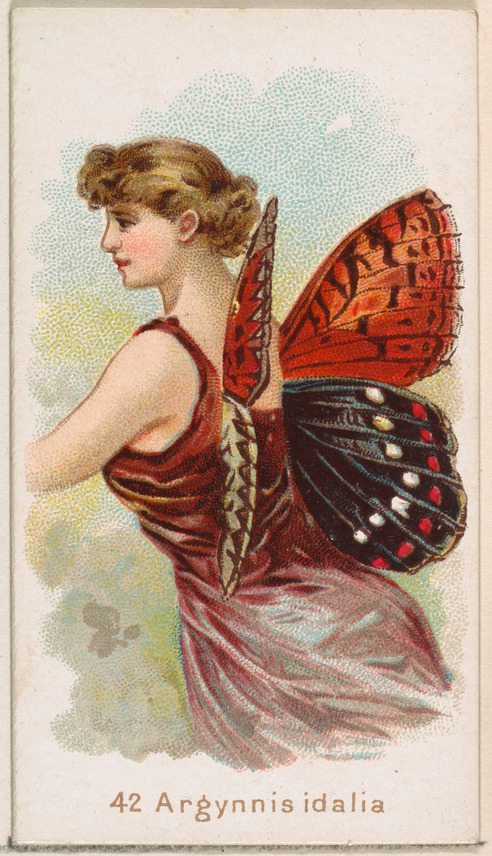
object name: print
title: Card 42, Argynnis Idalia, from the Butterflies series (N183) issued by Wm. S. Kimball & Co.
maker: william s. kimball & company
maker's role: publisher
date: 1888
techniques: color lithograph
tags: profiles,women,butterflies